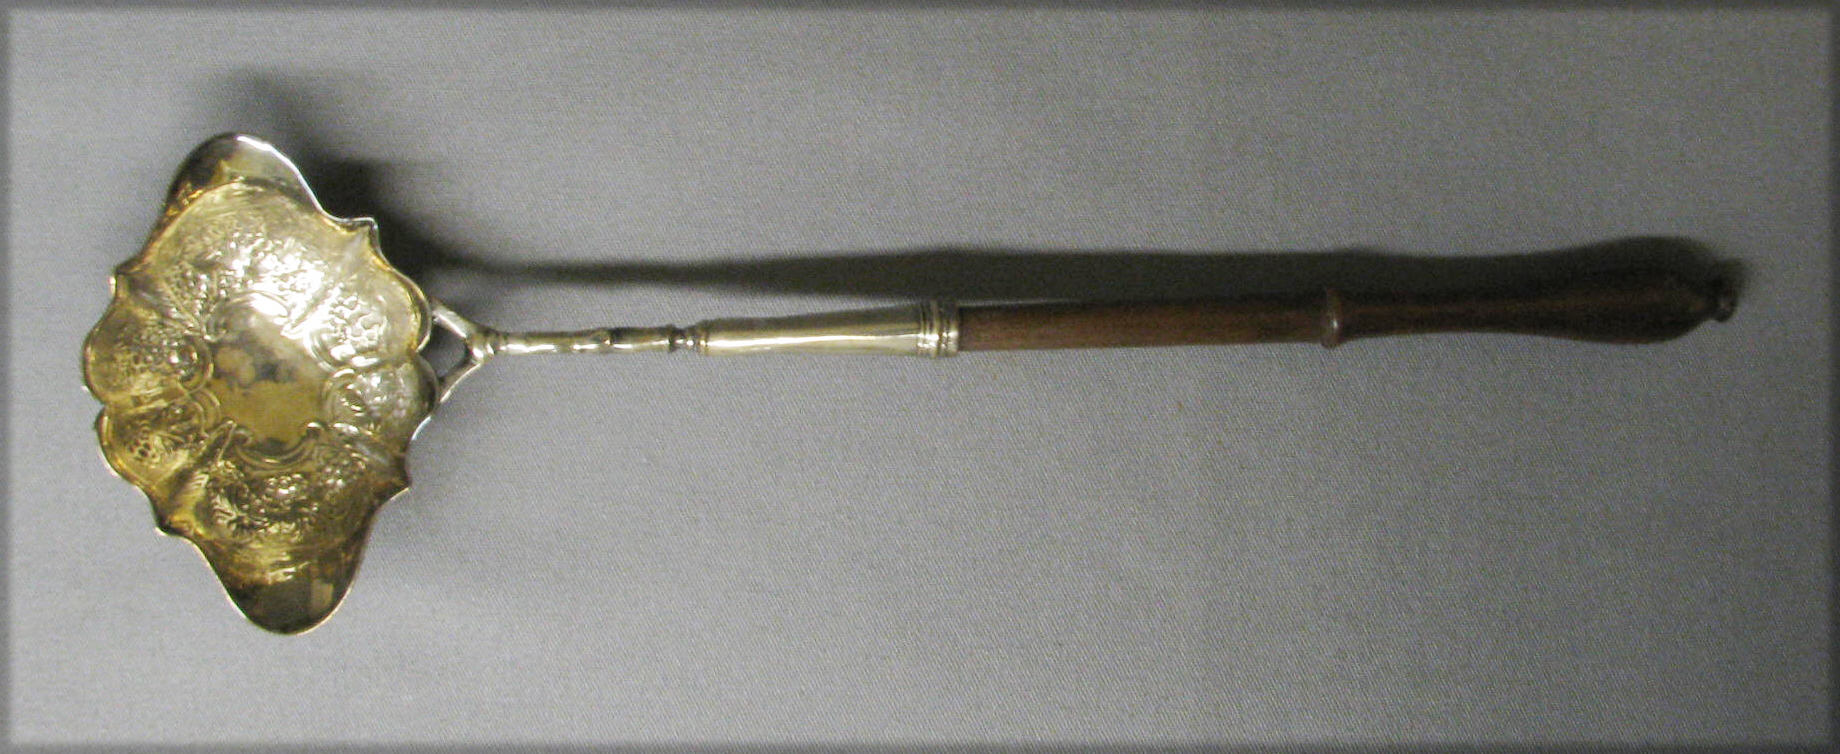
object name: ladle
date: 1751-1752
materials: silver